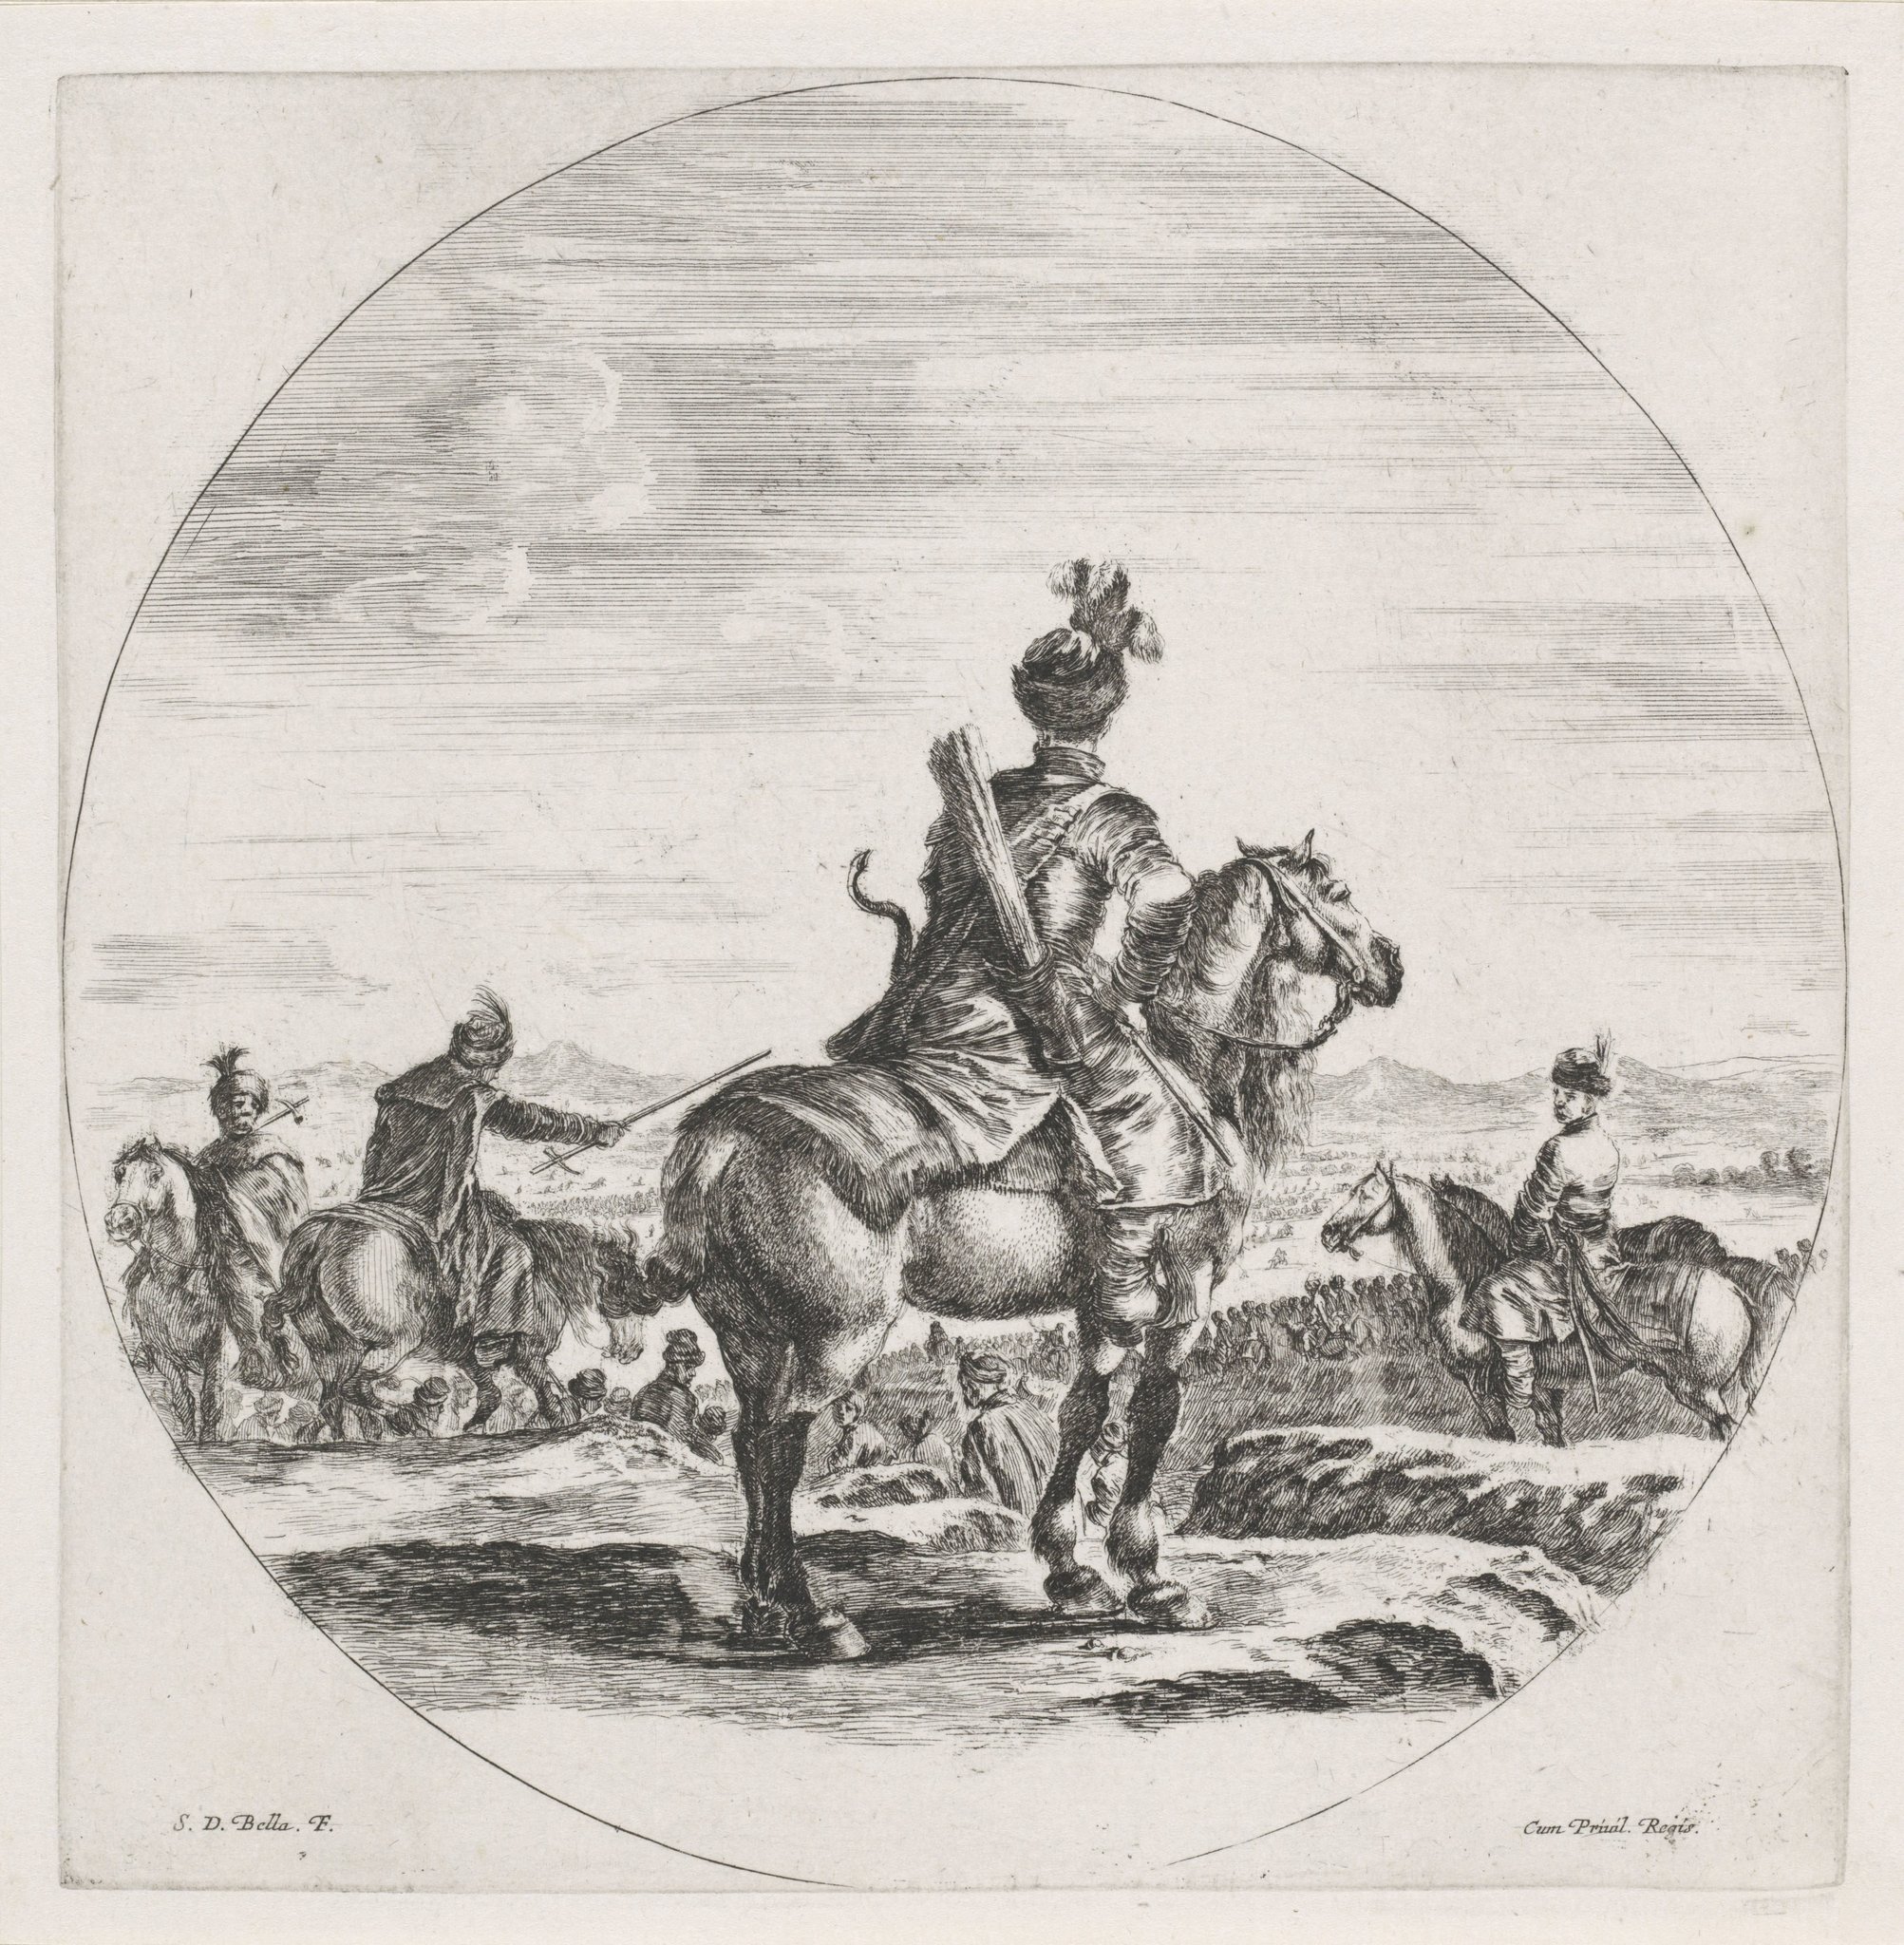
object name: print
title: Poolse man te paard op de rug gezien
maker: stefano della bella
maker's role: draughtsman, print maker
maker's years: 1610-1664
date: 1620-1664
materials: paper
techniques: etching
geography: france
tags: europeans, riding a horse, ass, or mule; rider, horseman, the soldier; the soldier's life, horse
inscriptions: collector's mark: Lugt 240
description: Een Poolse man te paard op de rug gezien, uitkijkend over een vlakte. Op zijn rug hangen pijlen en een boog. Rechts een ruiter te paard en links twee ruiters te paard. Op de achtergrond lopen troepen over de vlakte.